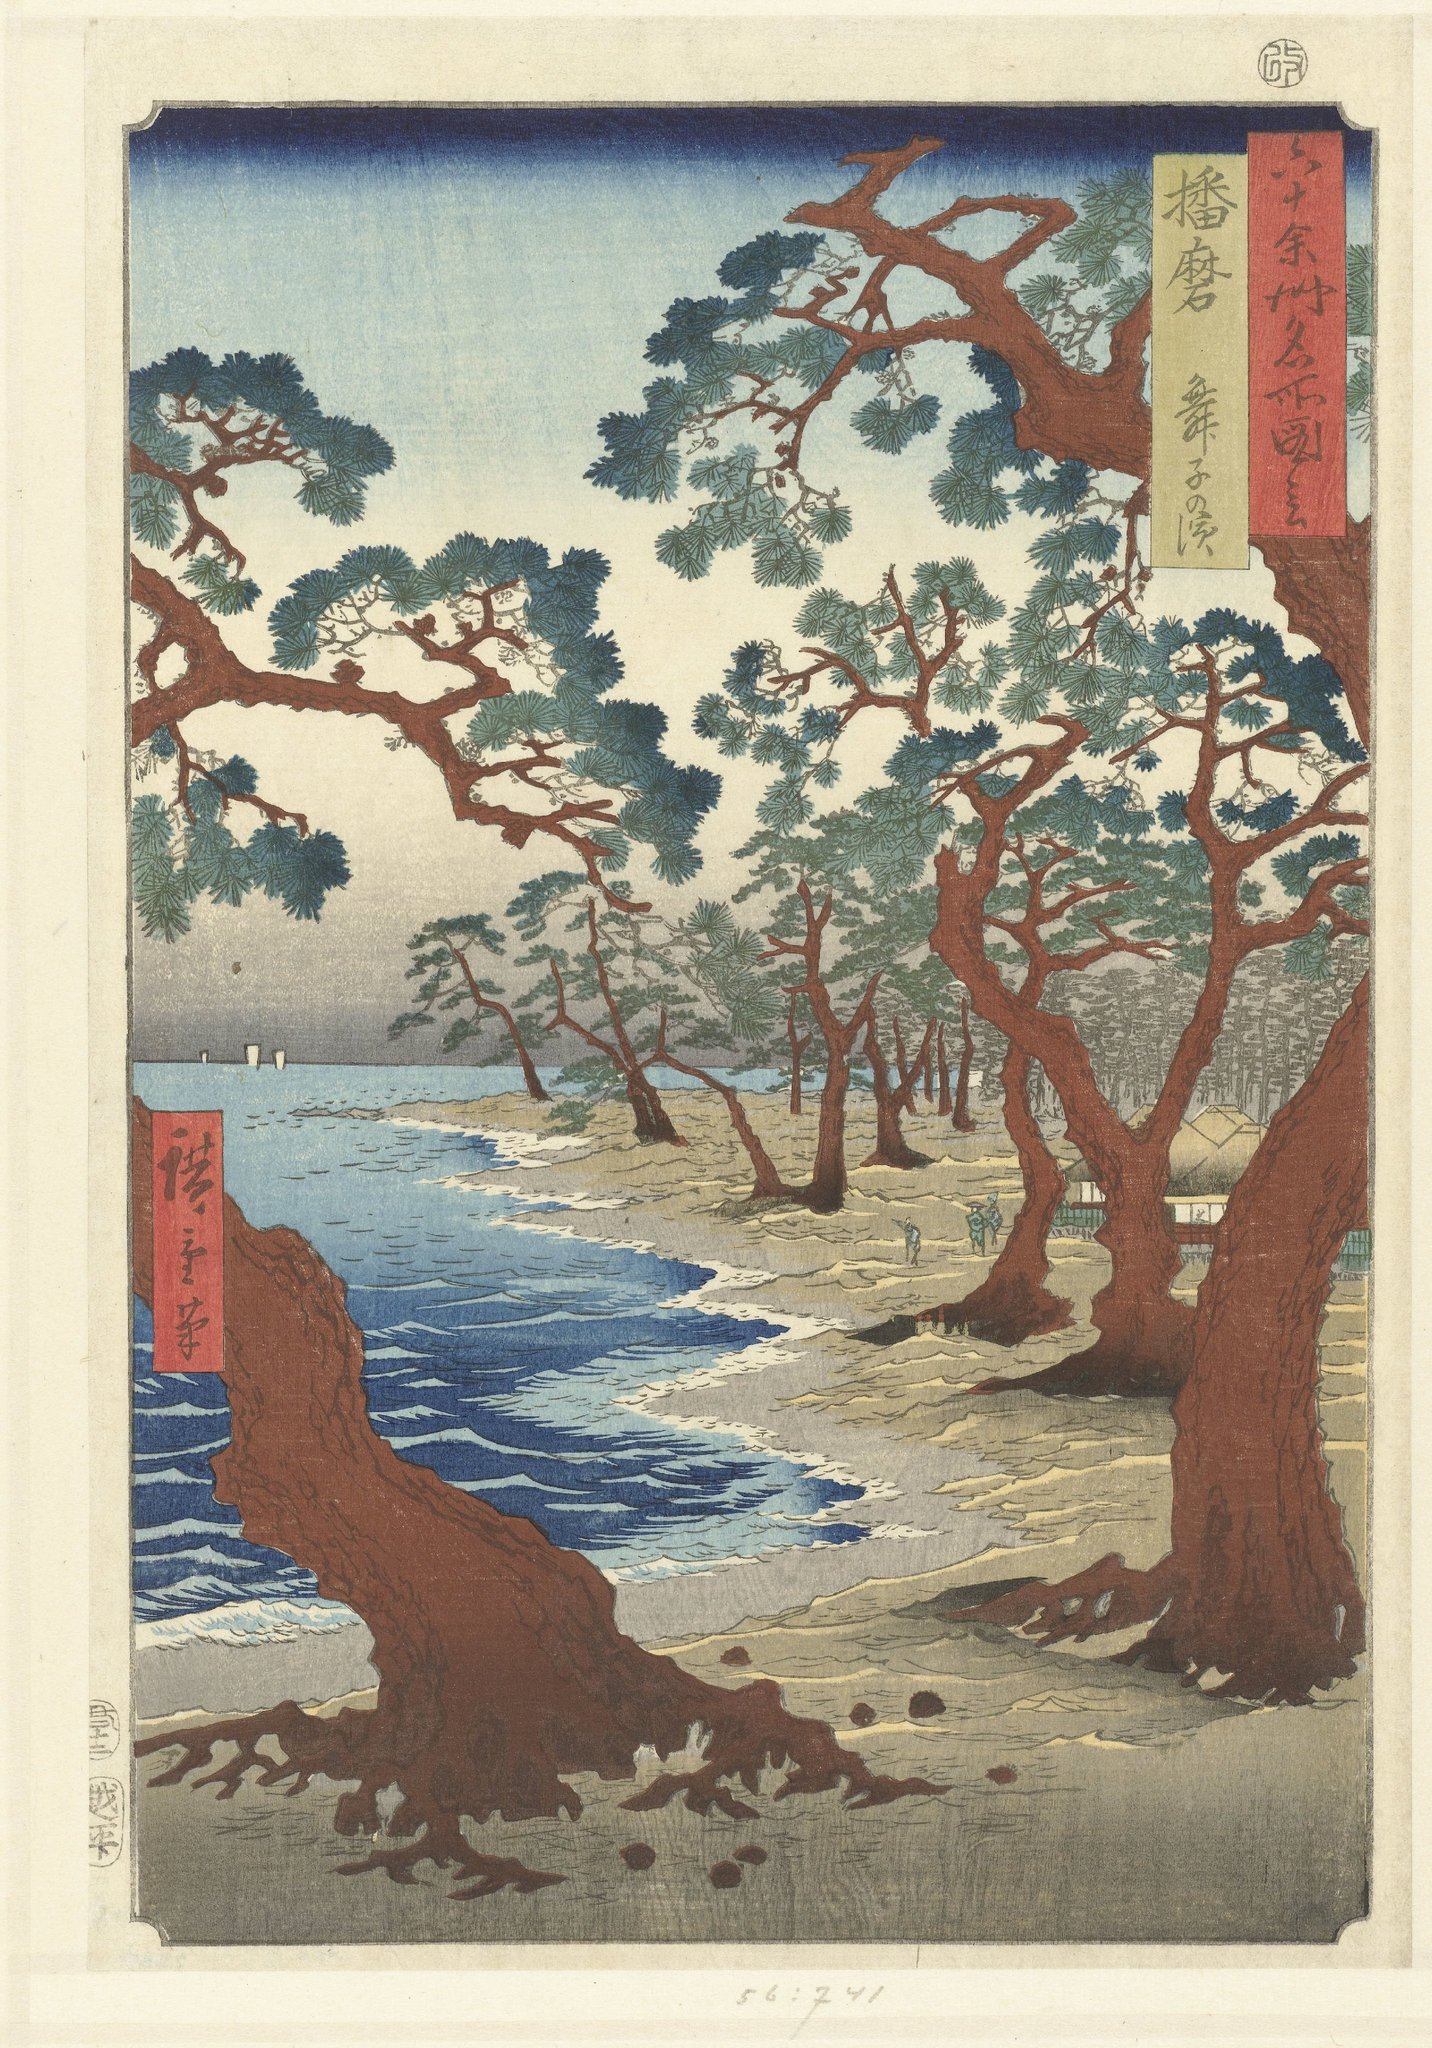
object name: print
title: Rokuju yoshu meisho zue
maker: utagawa hiroshige (i)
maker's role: draughtsman, print maker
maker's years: 1797-1858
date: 1853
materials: paper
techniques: woodcut, nishiki e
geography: japan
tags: trees, beach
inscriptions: date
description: Gezicht op de beroemde oude grillige pijnbomen op het strand in de provincie Harima; op de achtergrond een theehuis.